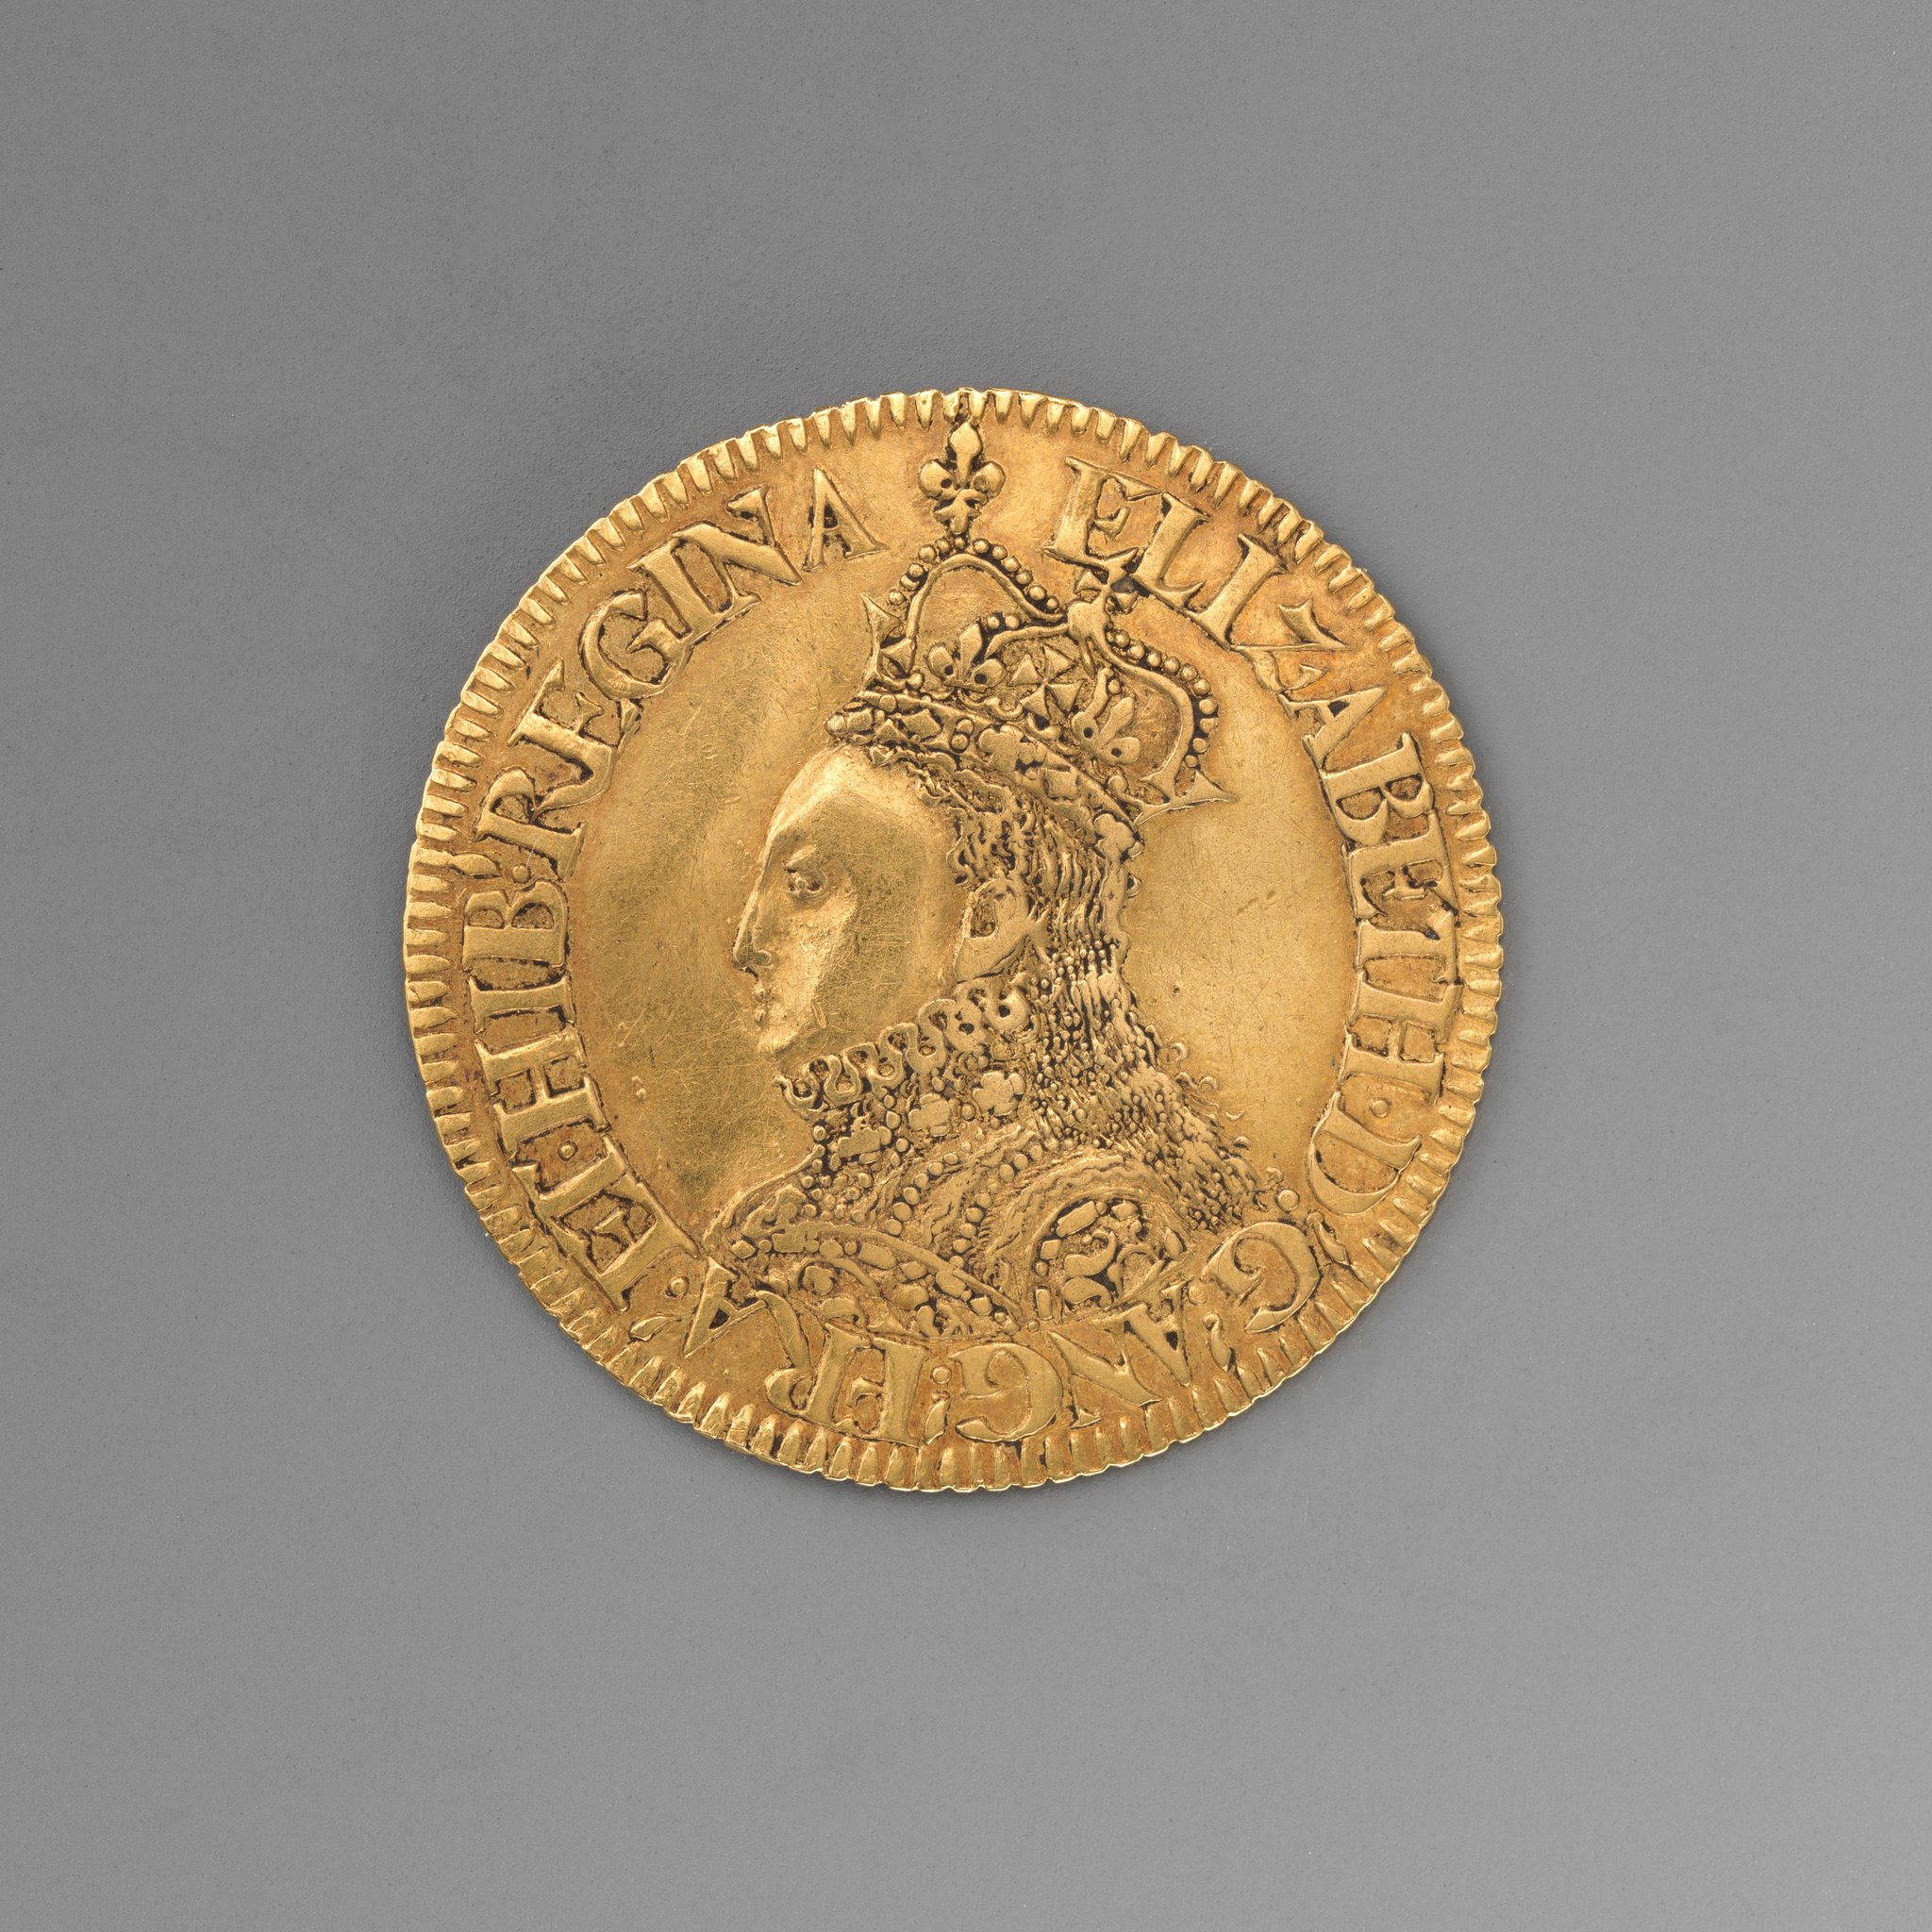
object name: half pound coin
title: Half pound of Elizabeth I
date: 1561-1570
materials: gold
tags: elizabeth i,profiles,coins,coat of arms